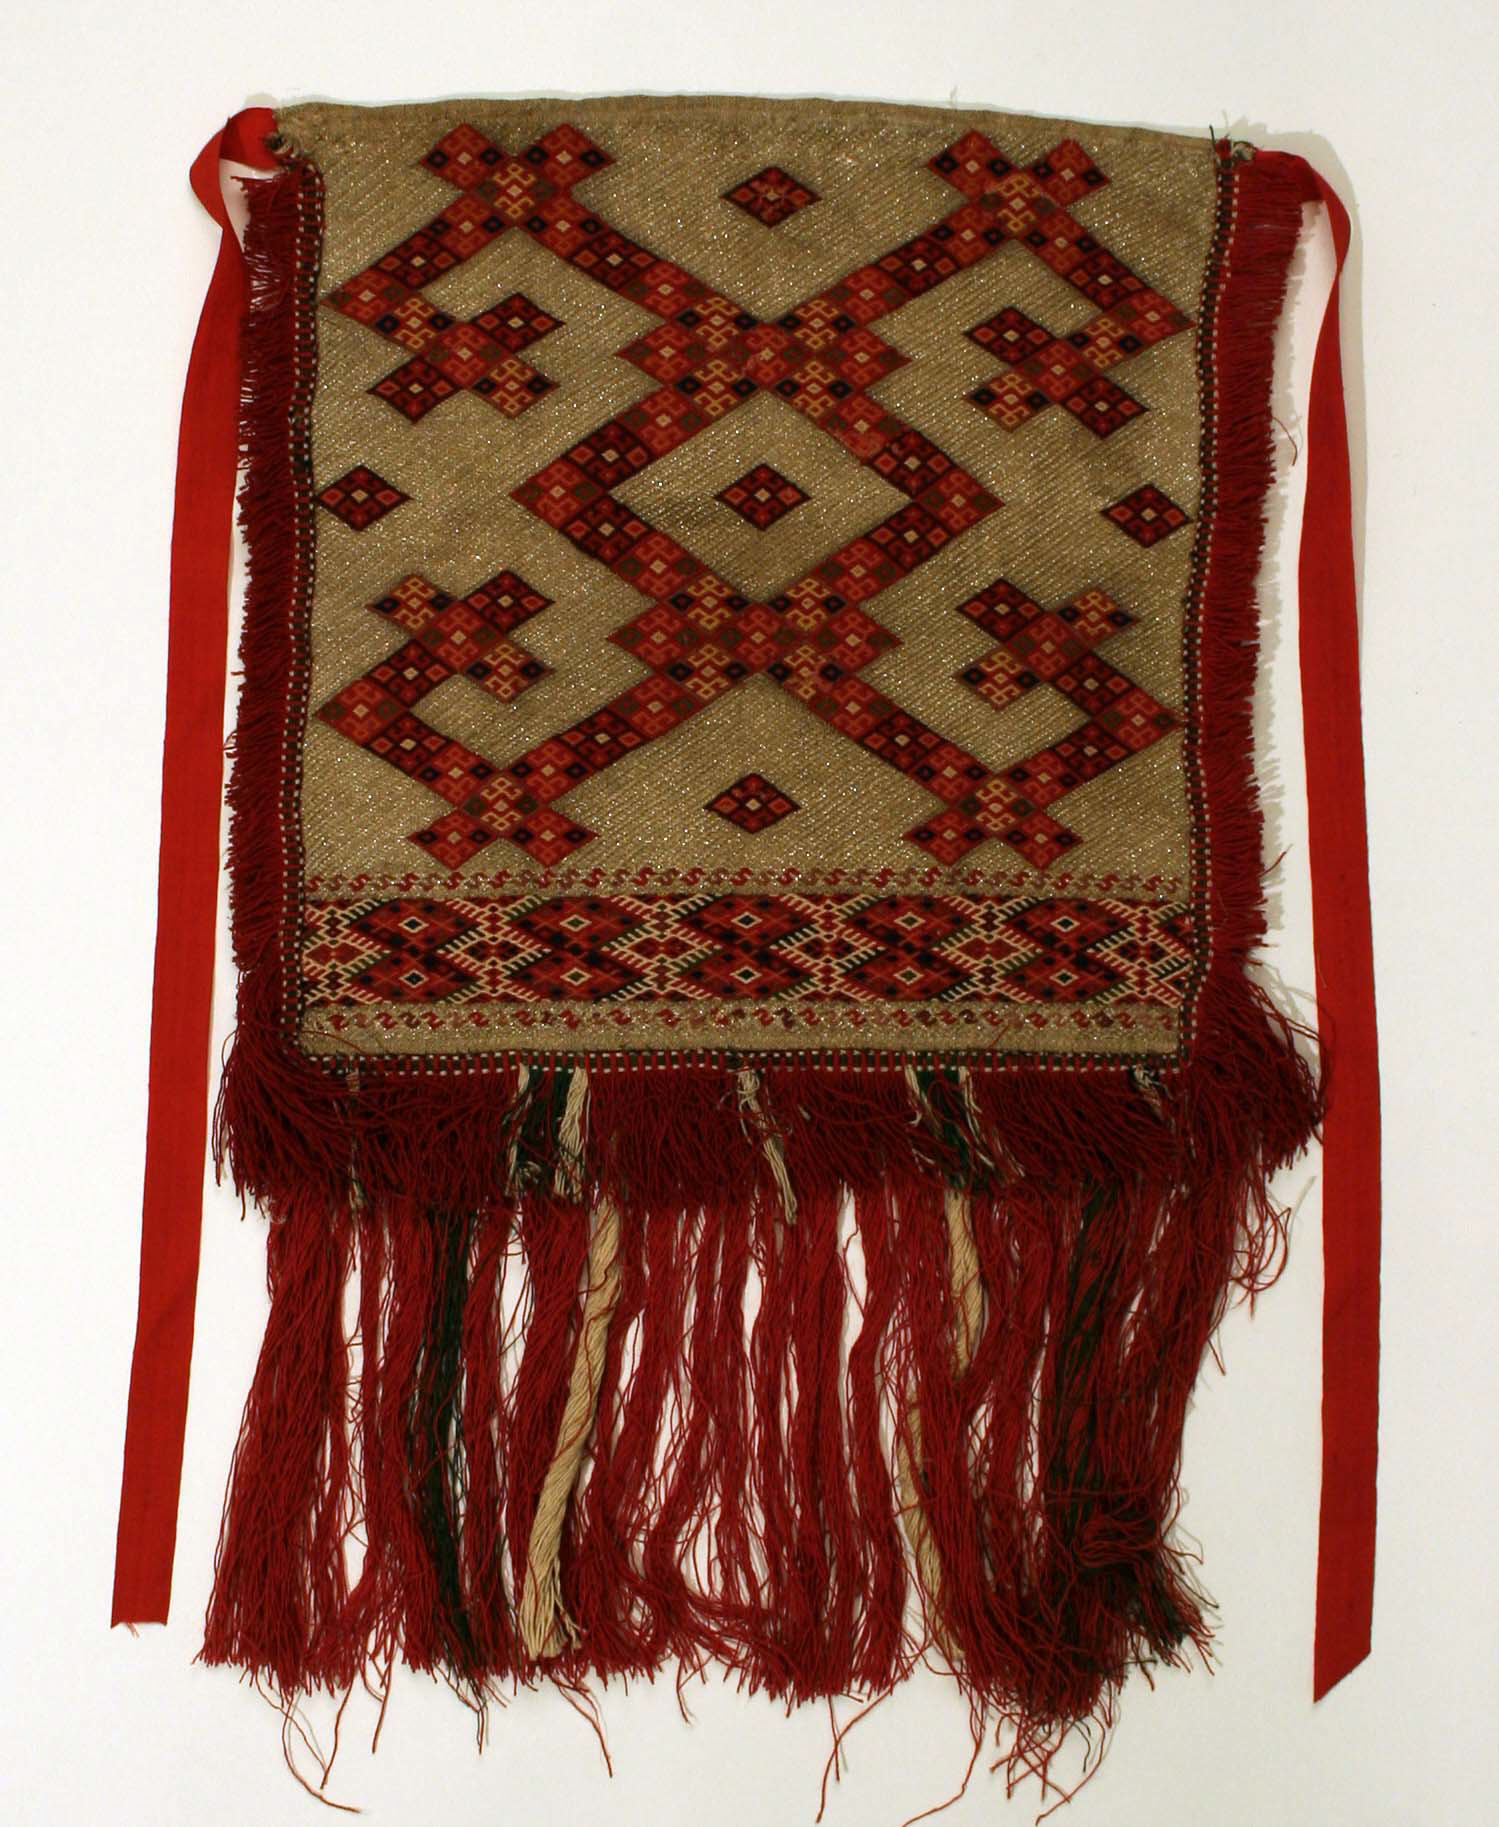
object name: apron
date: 1801-1900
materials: linen, wool